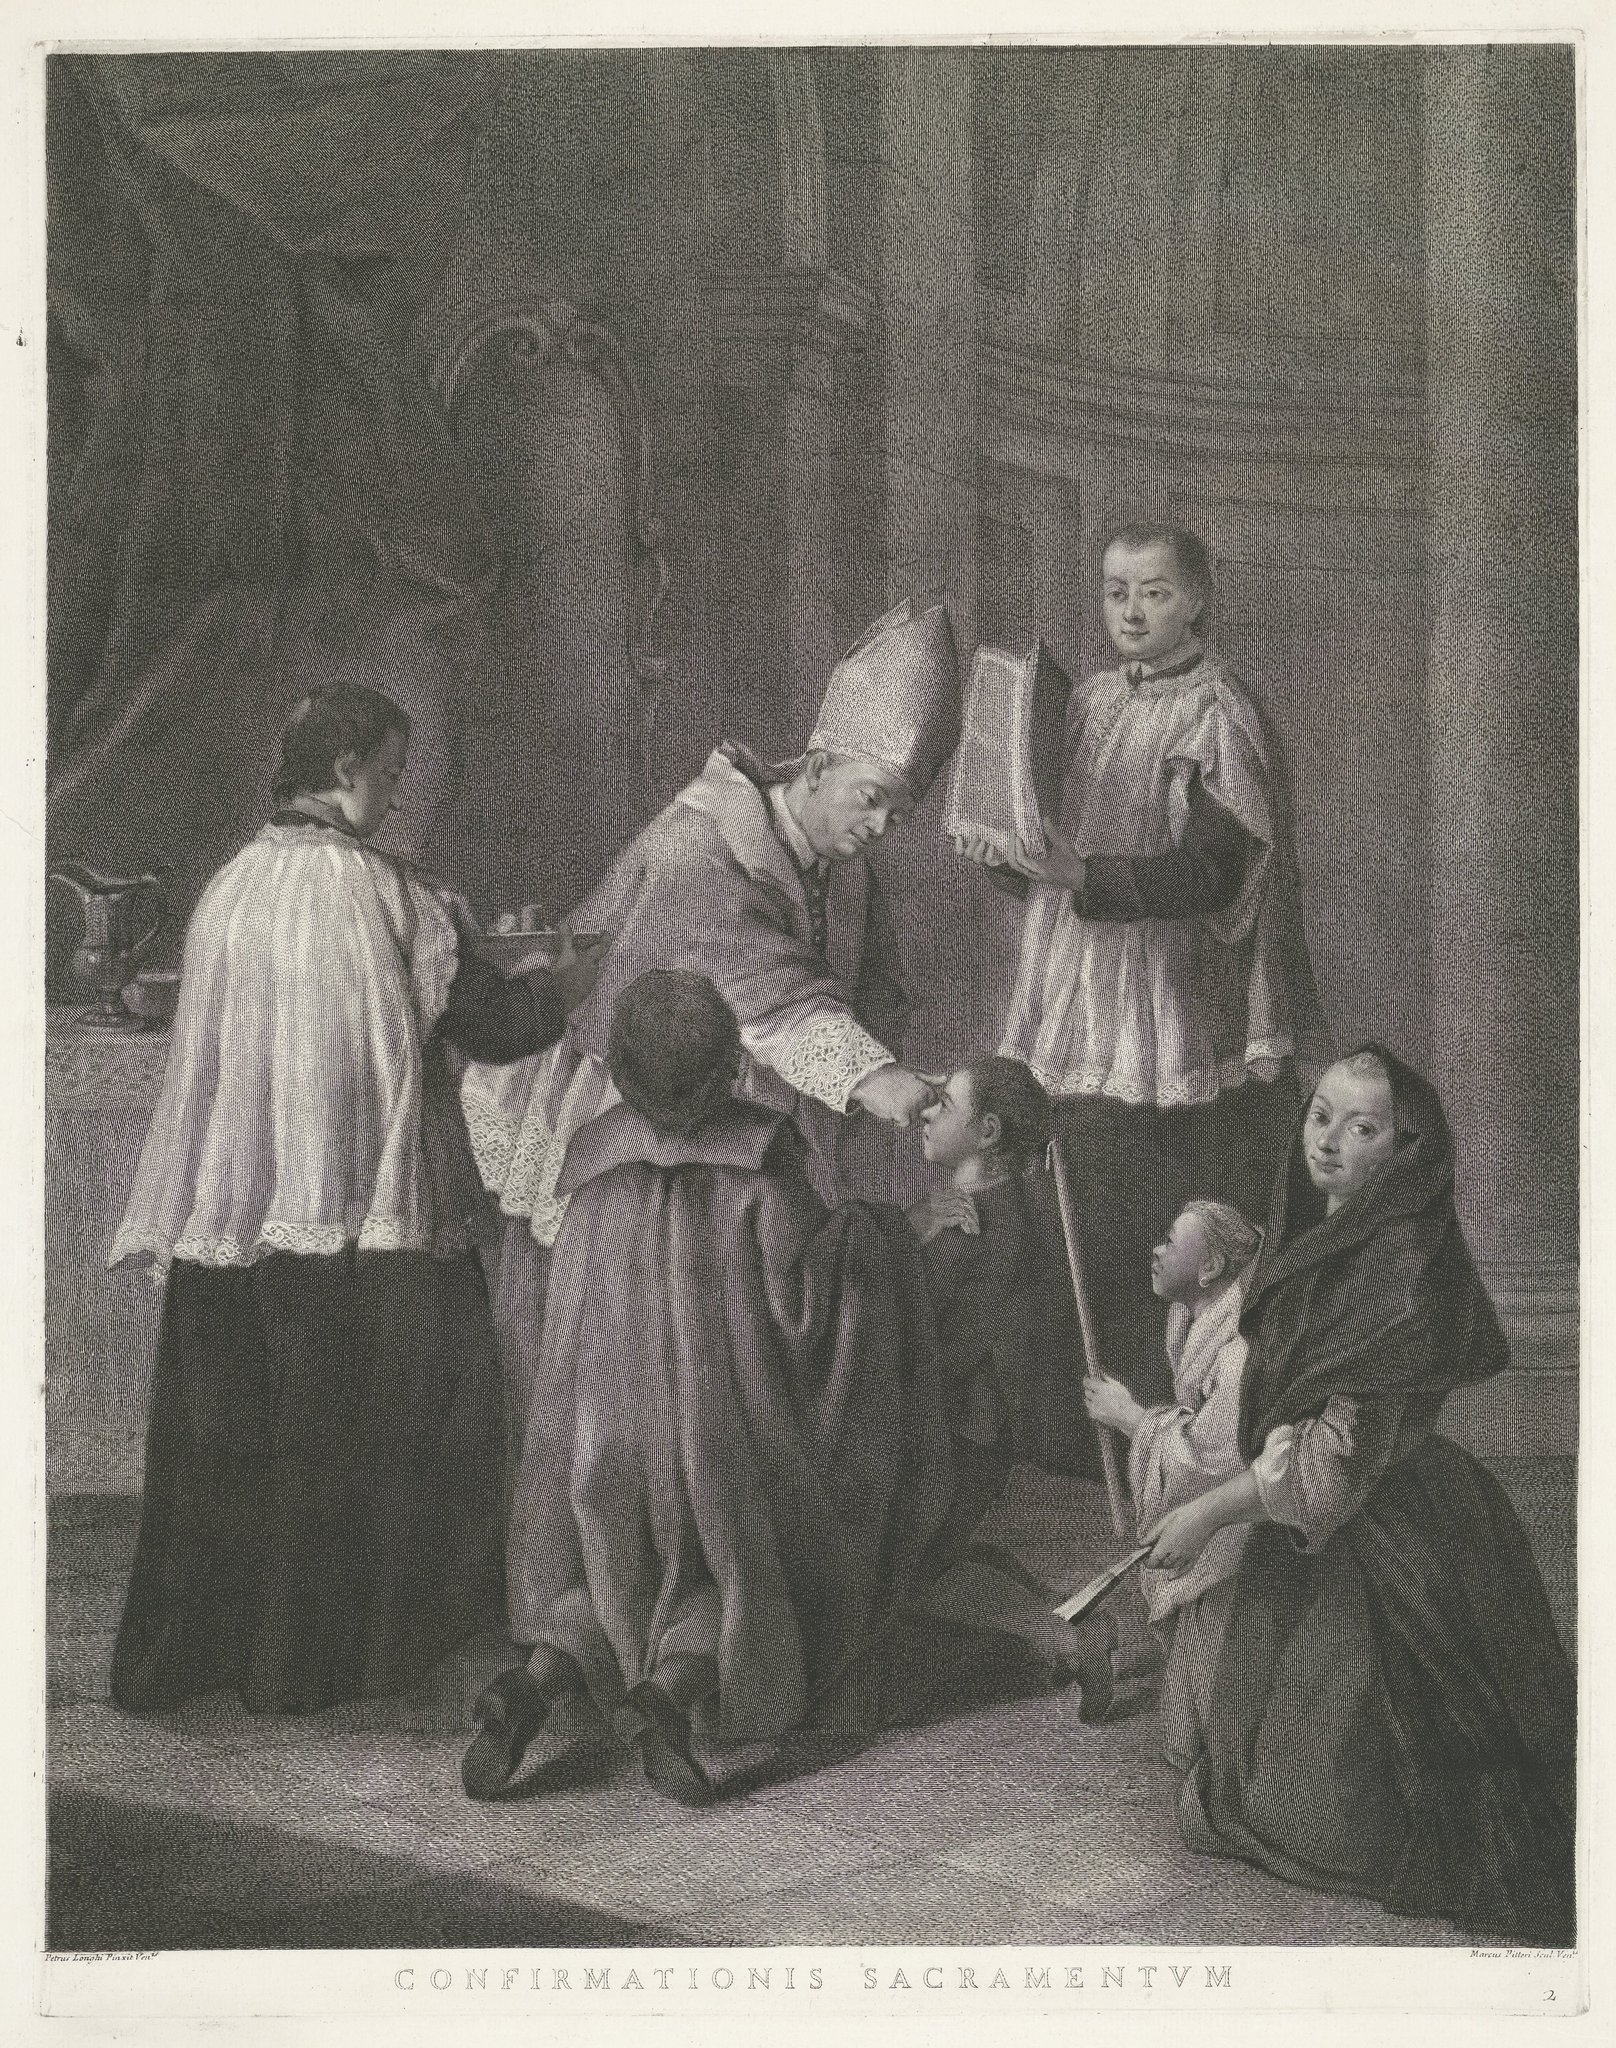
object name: print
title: Zeven sacramenten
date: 1712-1786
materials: paper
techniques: engraving, etching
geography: venice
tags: the seven sacraments of the roman catholic church, confirmation ~ the second of the seven sacraments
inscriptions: collector's mark: Lugt 240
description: Het sacrament van het vormsel. Een knielende vormeling ontvangt de Heilige Geest van een priester. De familie van de jongen knielt rondom.